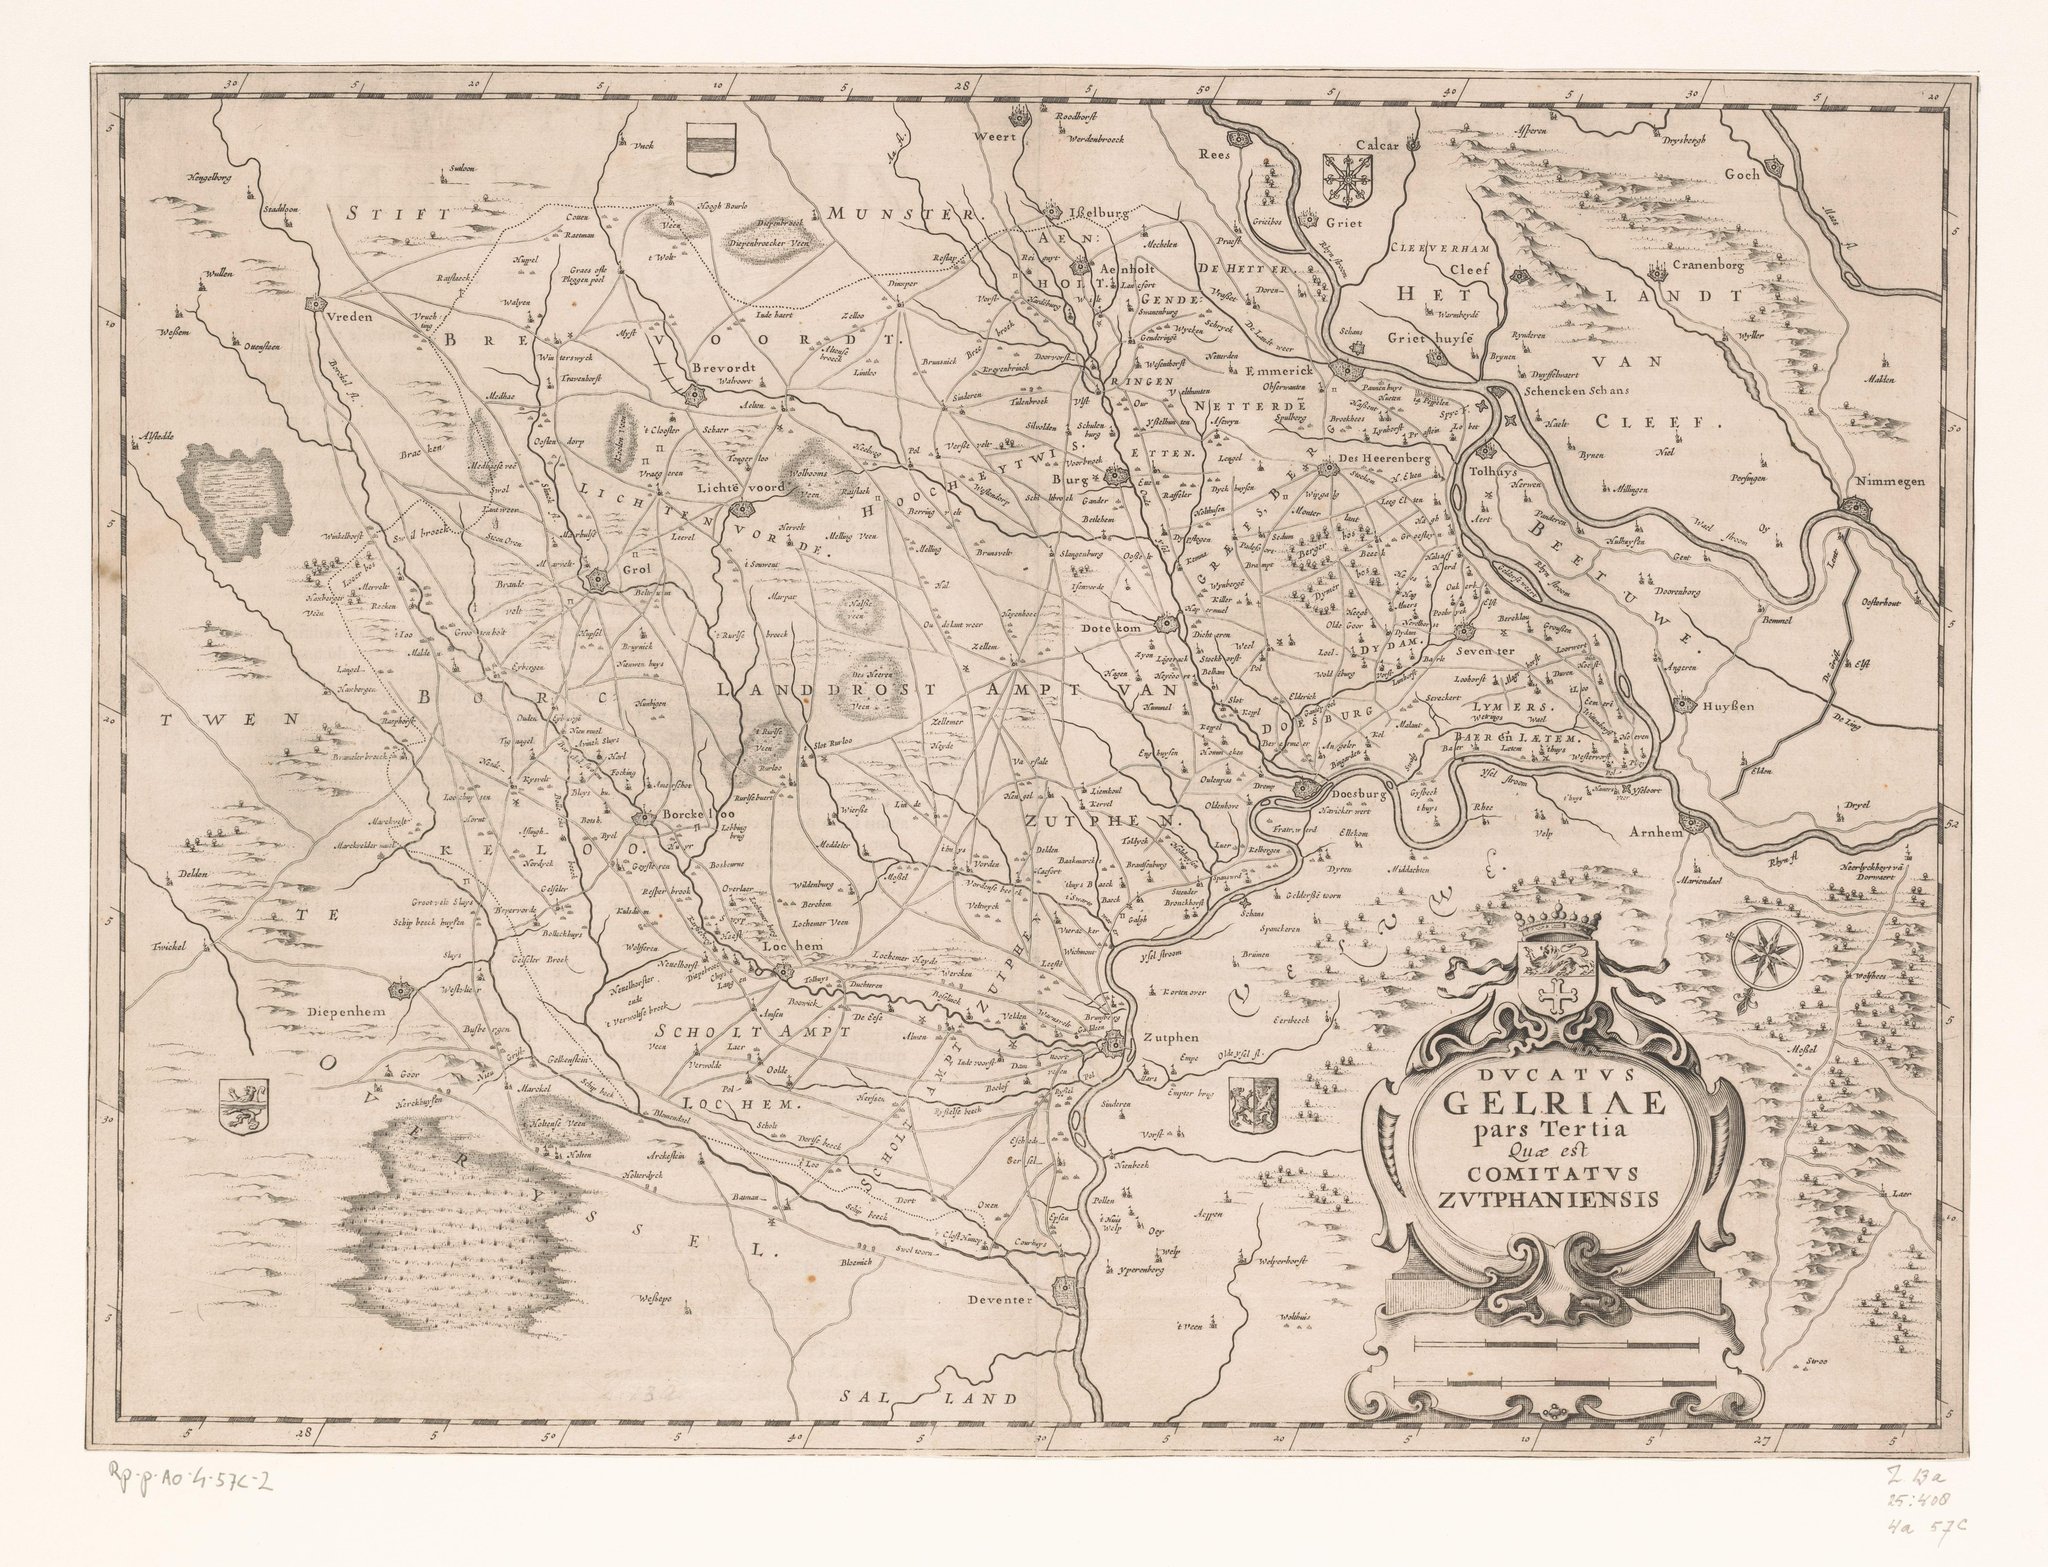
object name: map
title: Kaart van het graafschap Zutphen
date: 1675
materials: paper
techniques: engraving, etching, letterpress printing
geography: amsterdam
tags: coat of arms (as symbol of the state, etc.) (+ city; municipal), maps of separate countries or regions, gelderland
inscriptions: collector's mark: Lugt 2228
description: Rechtsonder de titelcartouche, met bovenin het wapen van de stad Zutphen en onderin twee schaalstokken. De kaart is voorzien van een gradenverdeling langs de randen. Met Latijnse tekst op verso.